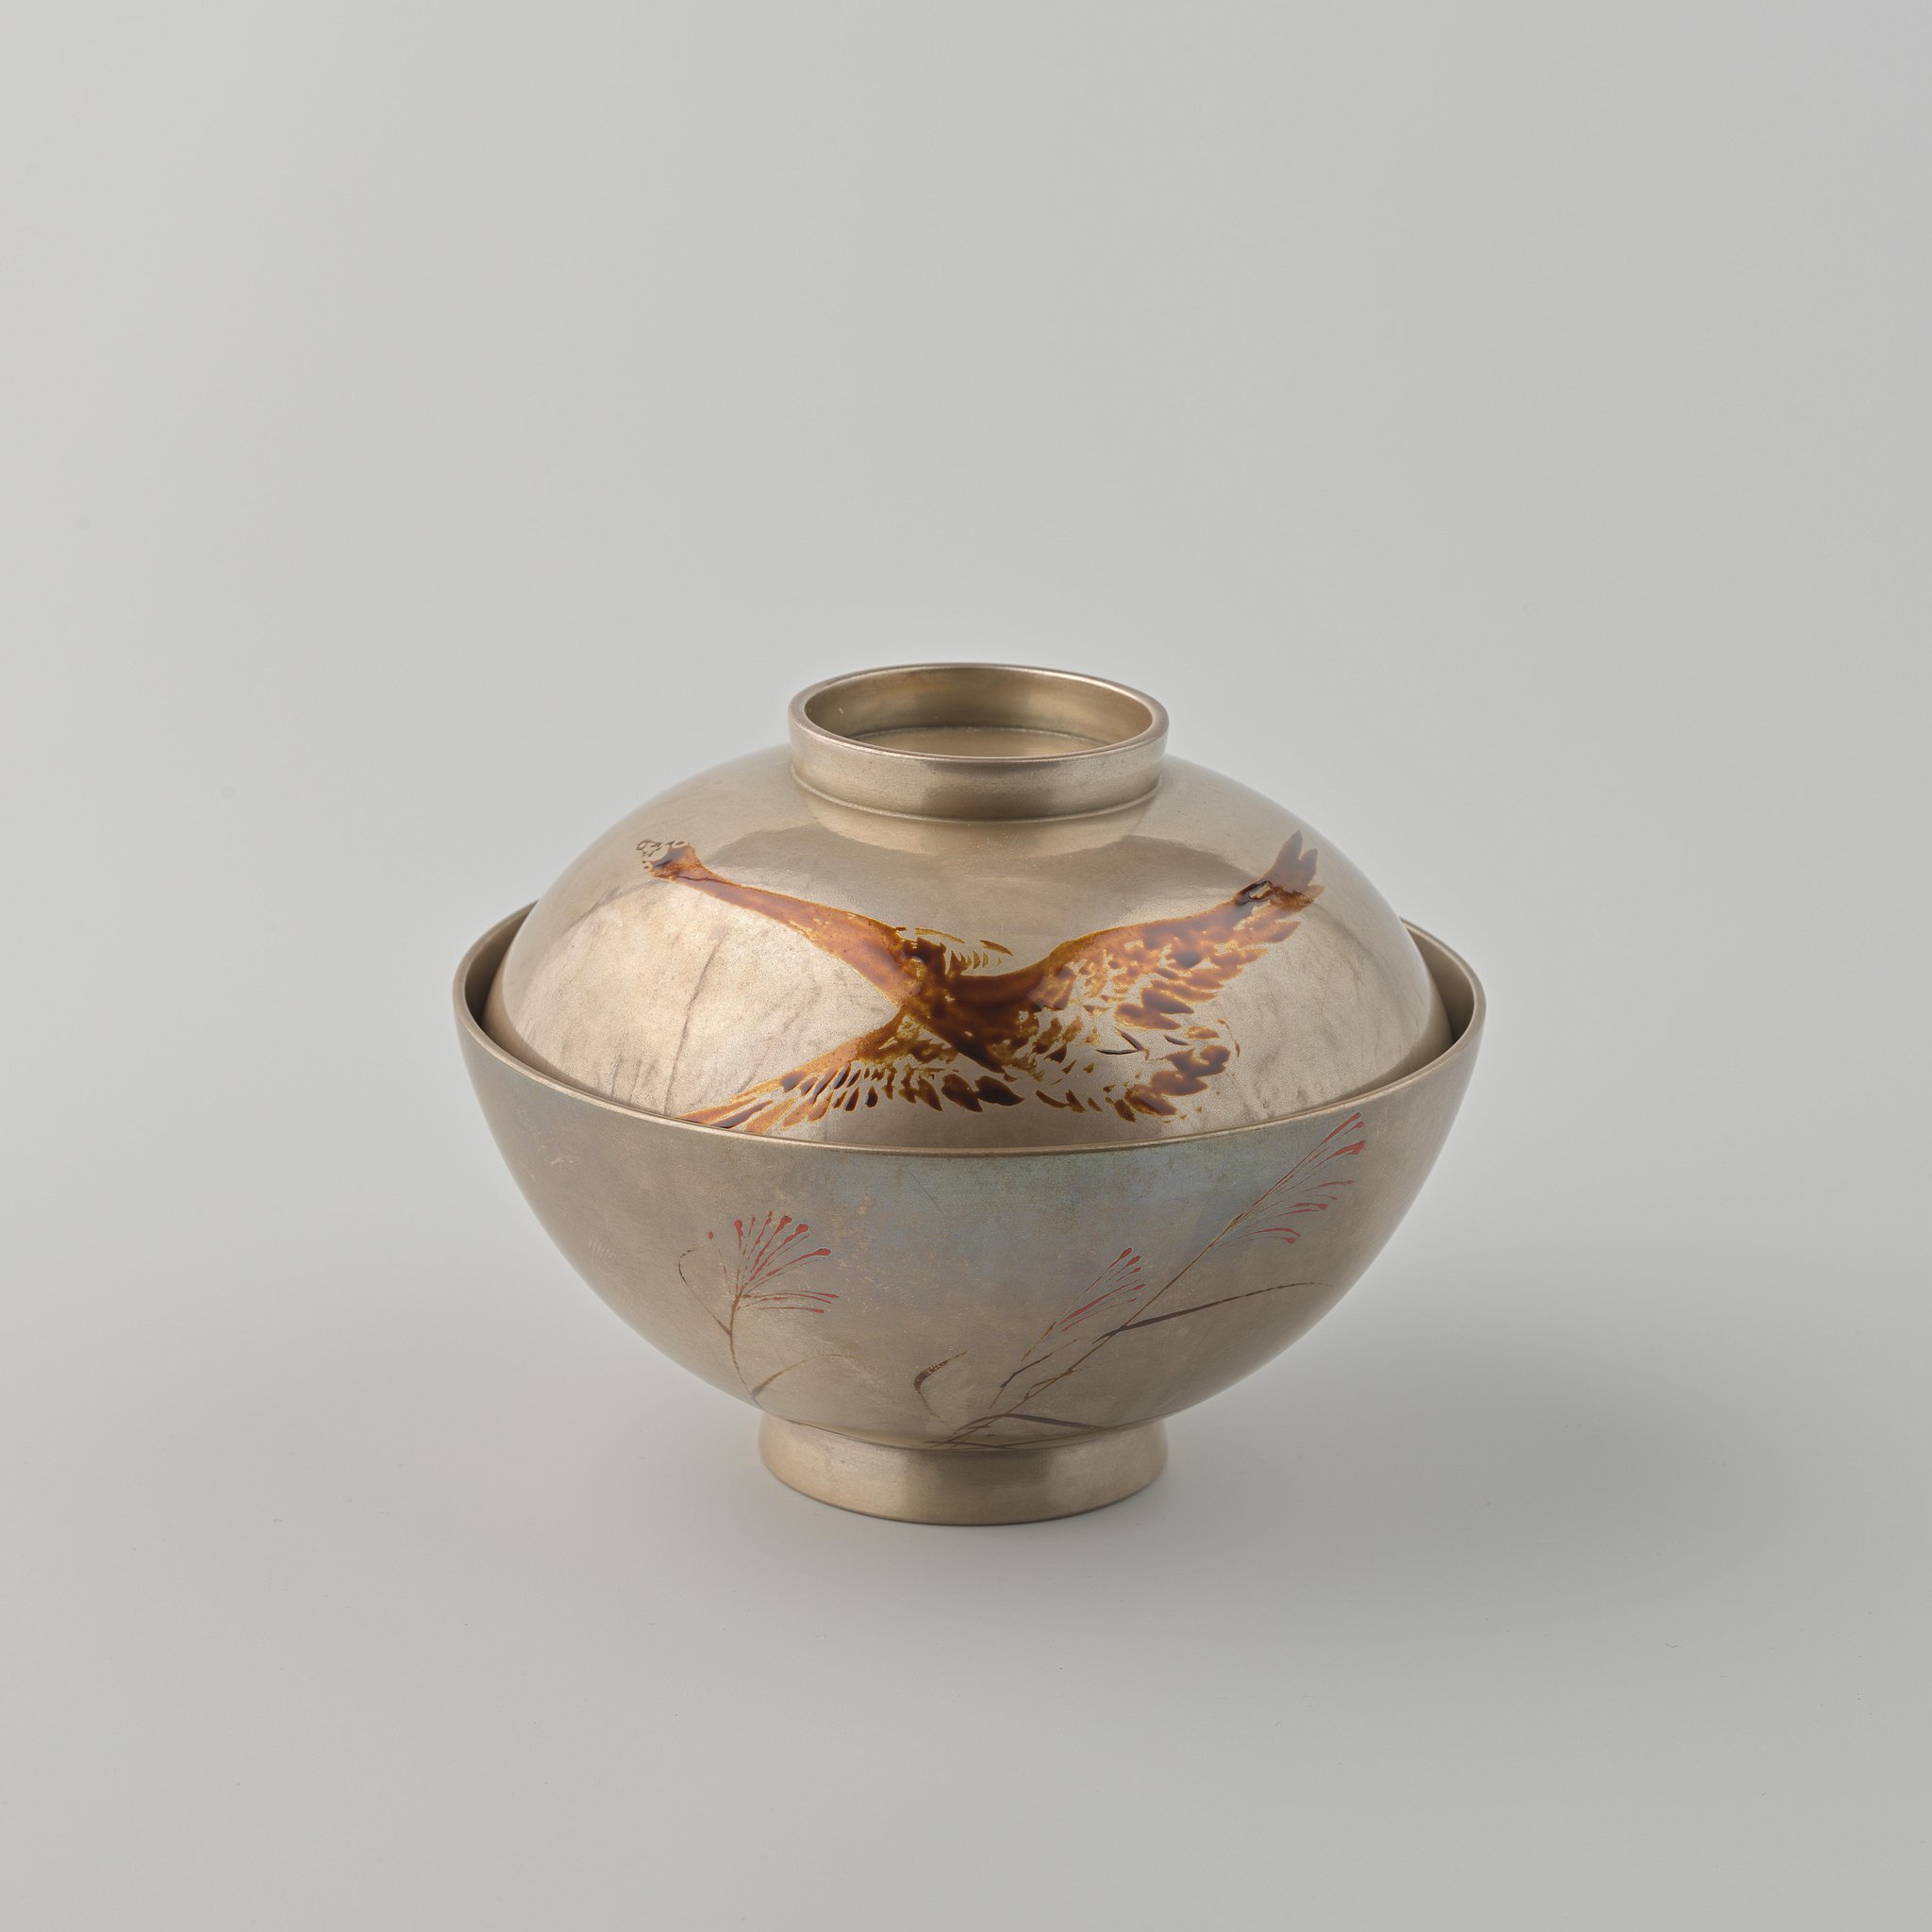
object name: bowl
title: Set of Bowls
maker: tanaka ikka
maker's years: 1864-1924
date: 1900-1920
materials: lacquer, wood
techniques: lacquer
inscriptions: signature: ‘Ikka ??? + kaō’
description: Ikka decorated the bowls and lids of this set with wellknown combinations of motifs from Japanese art, such as a goose with autumn grasses, irises with the bridges of Yatsuhashi, or a horse with a gourd. The latter pair is a reference to Chokaro, an immortal who on command could make a magic horse appear from his gourd.